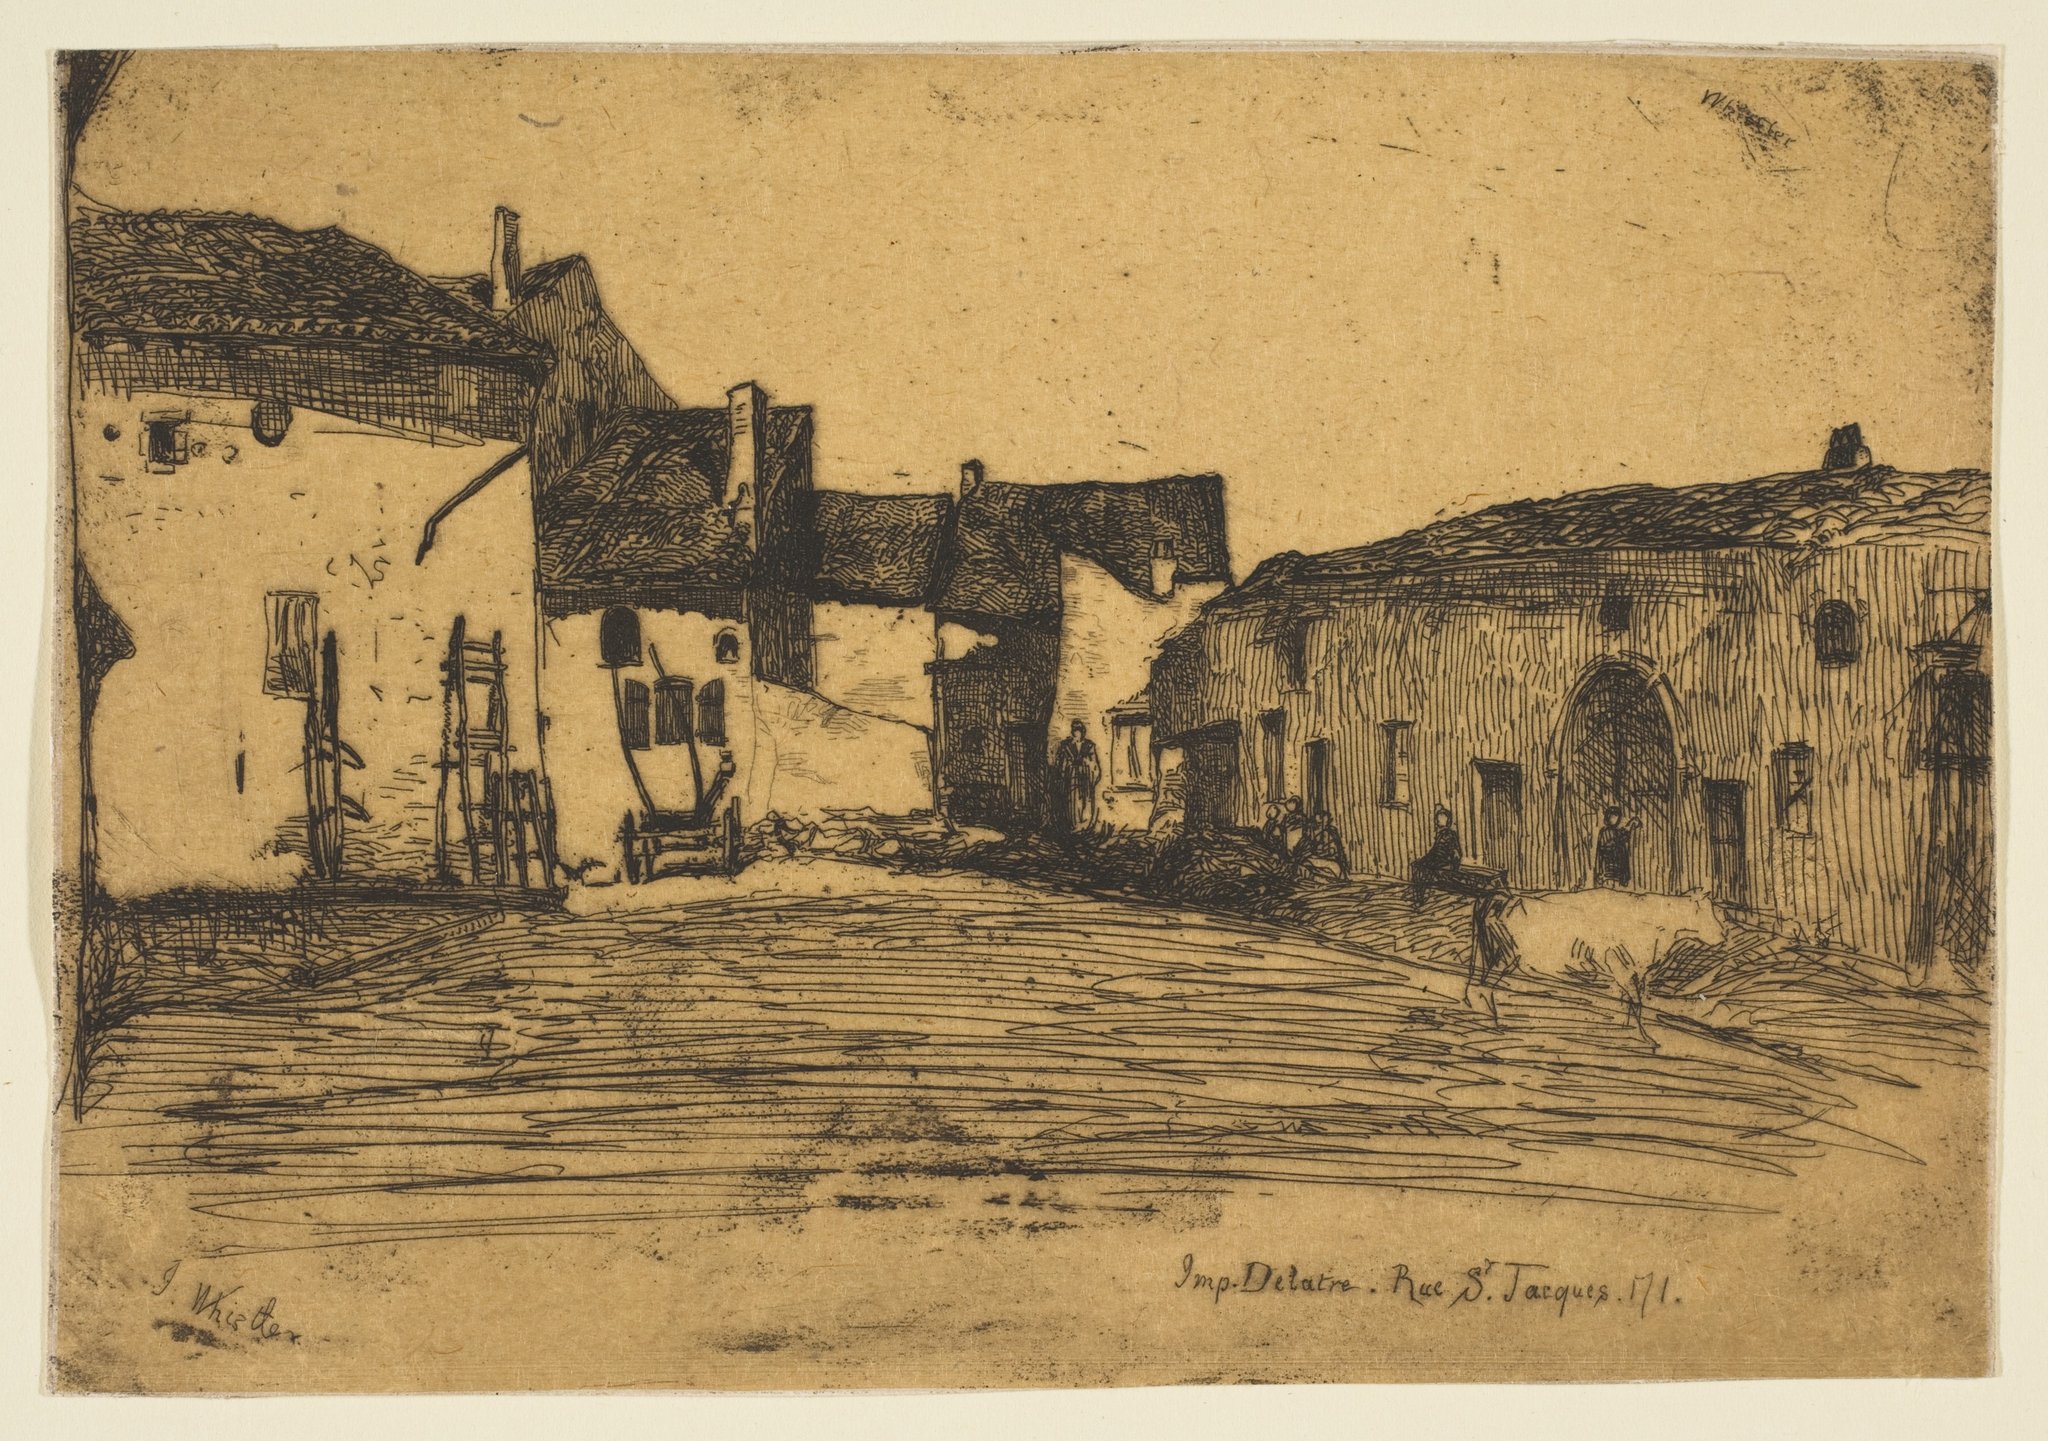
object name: print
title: Liverdun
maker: james mcneill whistler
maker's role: artist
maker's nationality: american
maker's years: 1834-1903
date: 1858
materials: chine, paper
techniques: printmaking, etching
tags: buildings